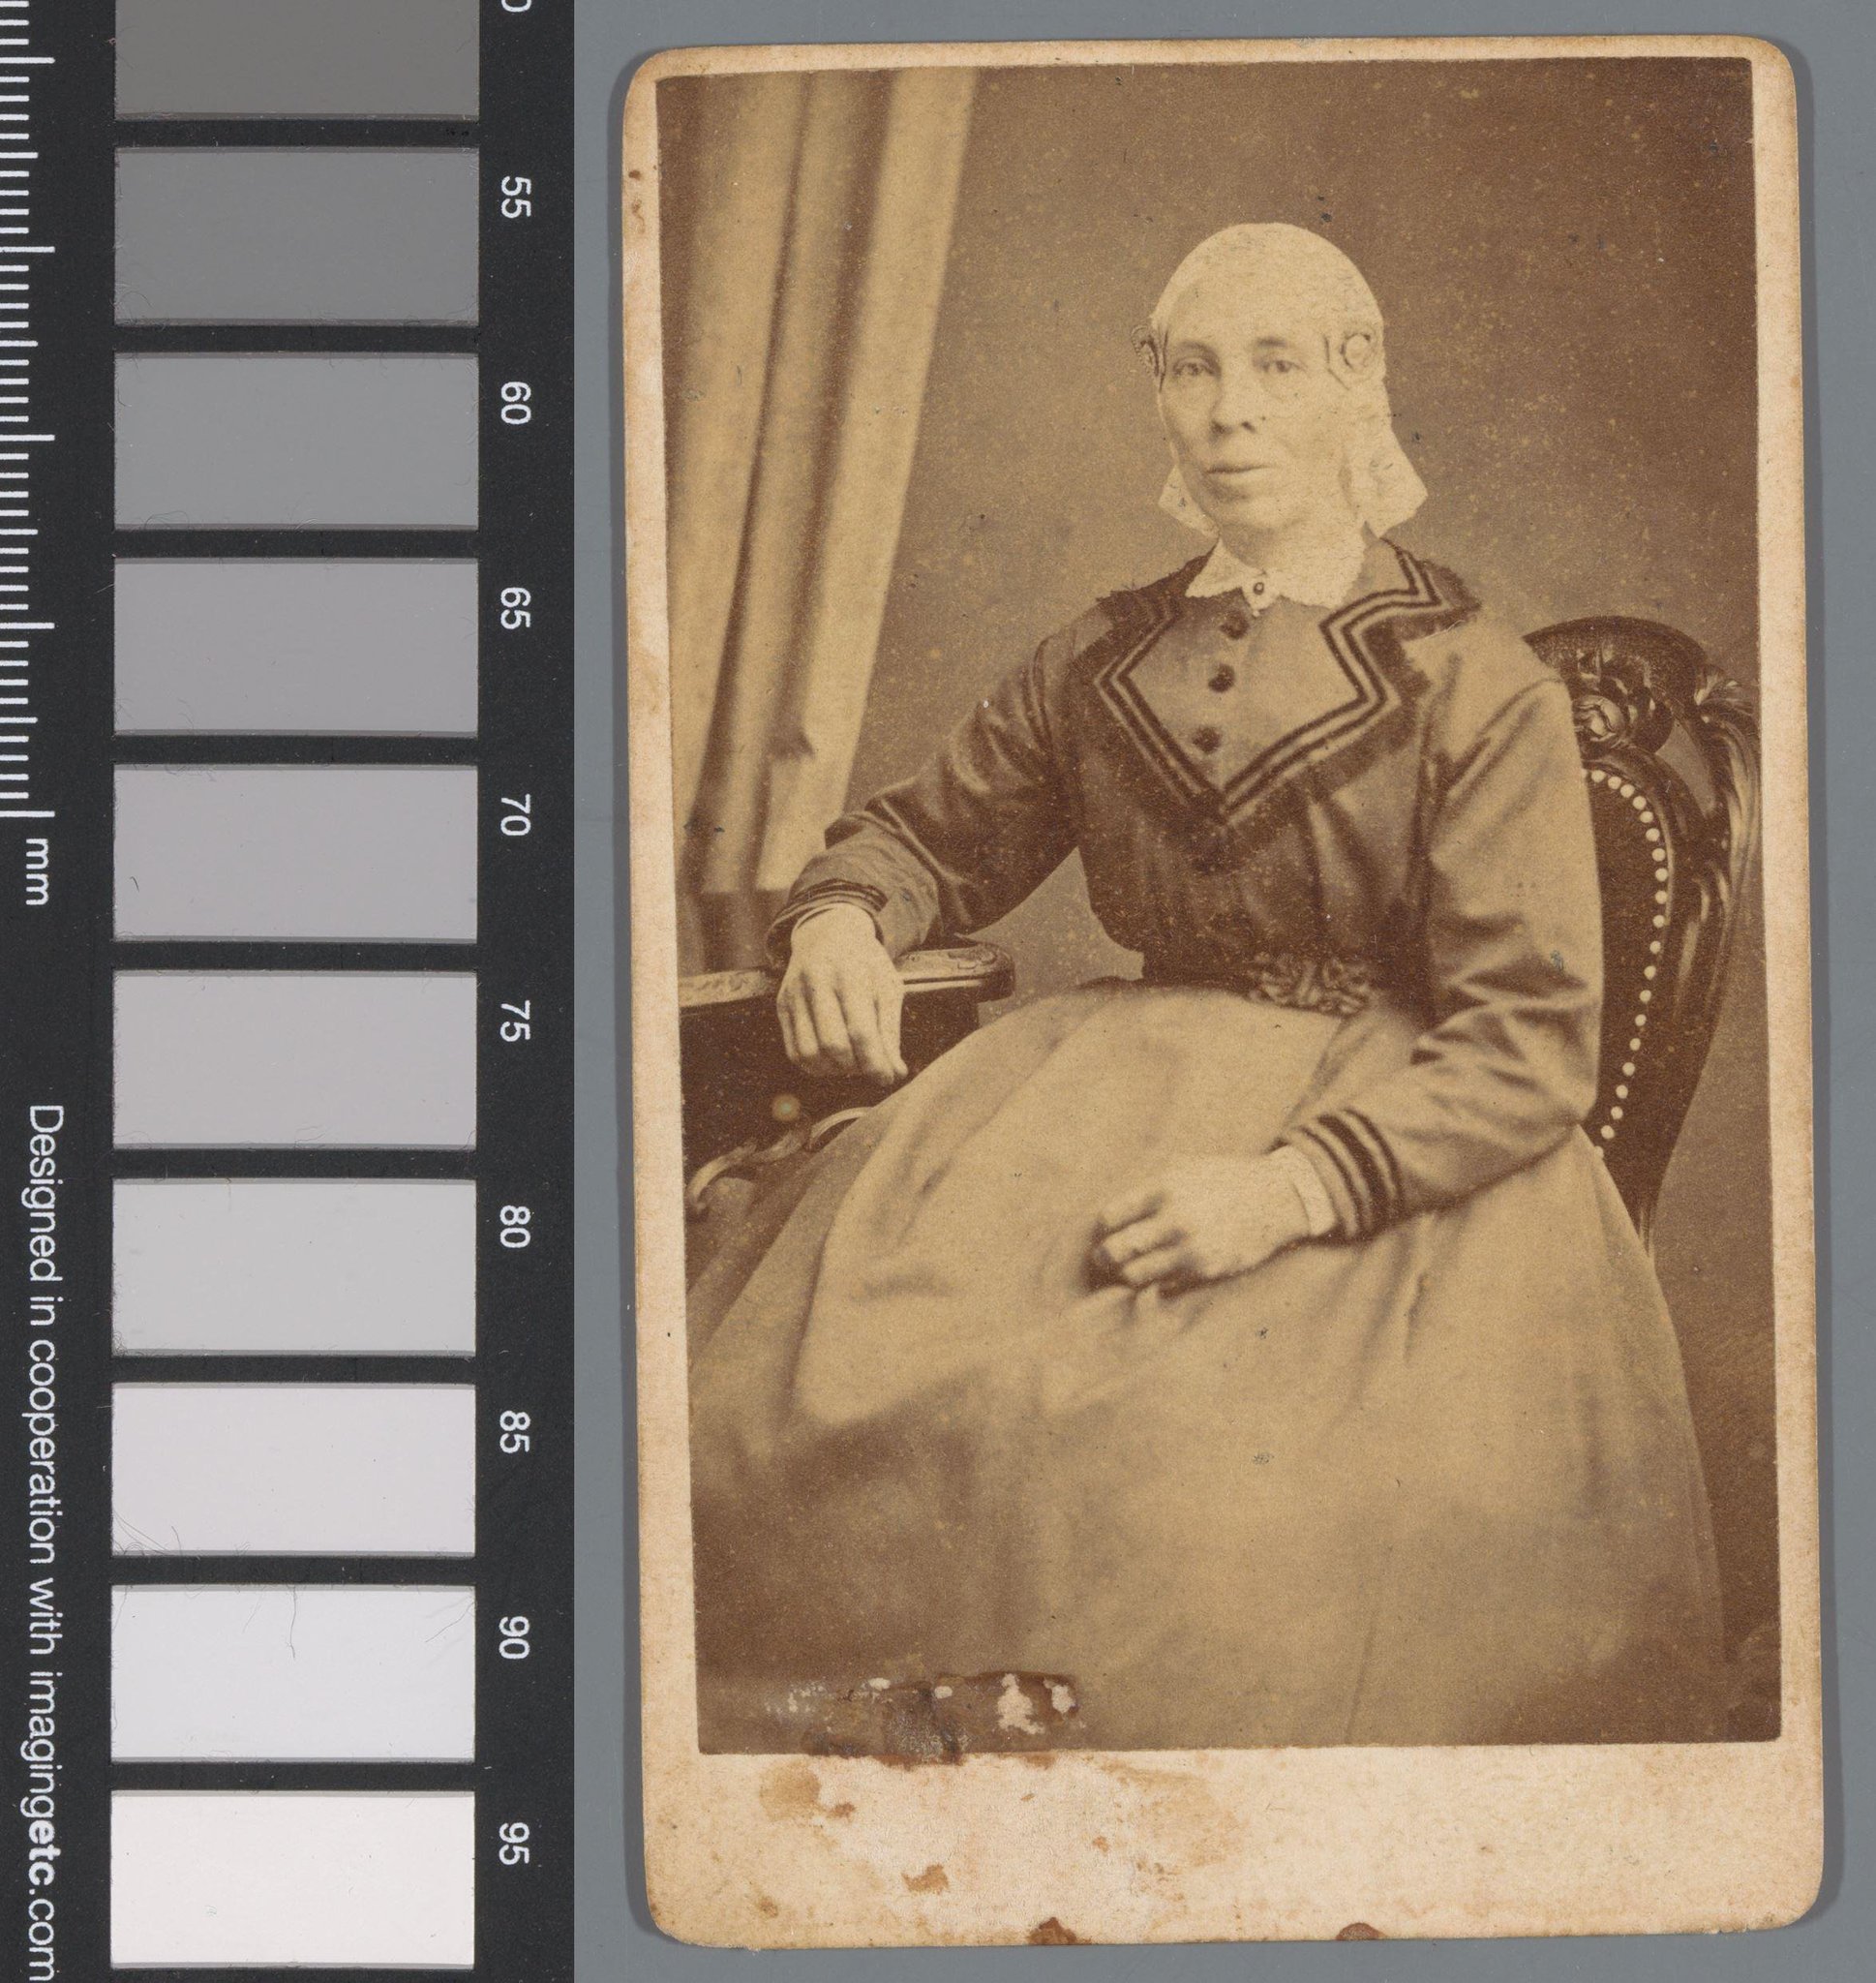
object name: carte de visite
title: Portret van een onbekende vrouw in Friese klederdracht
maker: hendrik anthonie karel ringler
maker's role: draughtsman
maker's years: 1846-1879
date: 1872-1879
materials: cardboard, paper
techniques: albumen print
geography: leeuwarden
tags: adult woman, anonymous historical person portrayed, folk costume, regional costume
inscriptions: inscription: ‘Photographisch/ Atelier/ van/ H.A.K. Ringler/ Leeuwarden/ Nieuwe Weststraat No/ tegenover het station/ Bolsward/ Dijkstraat No 206./ De plaaat blijft tot nabestelling bewaard.’